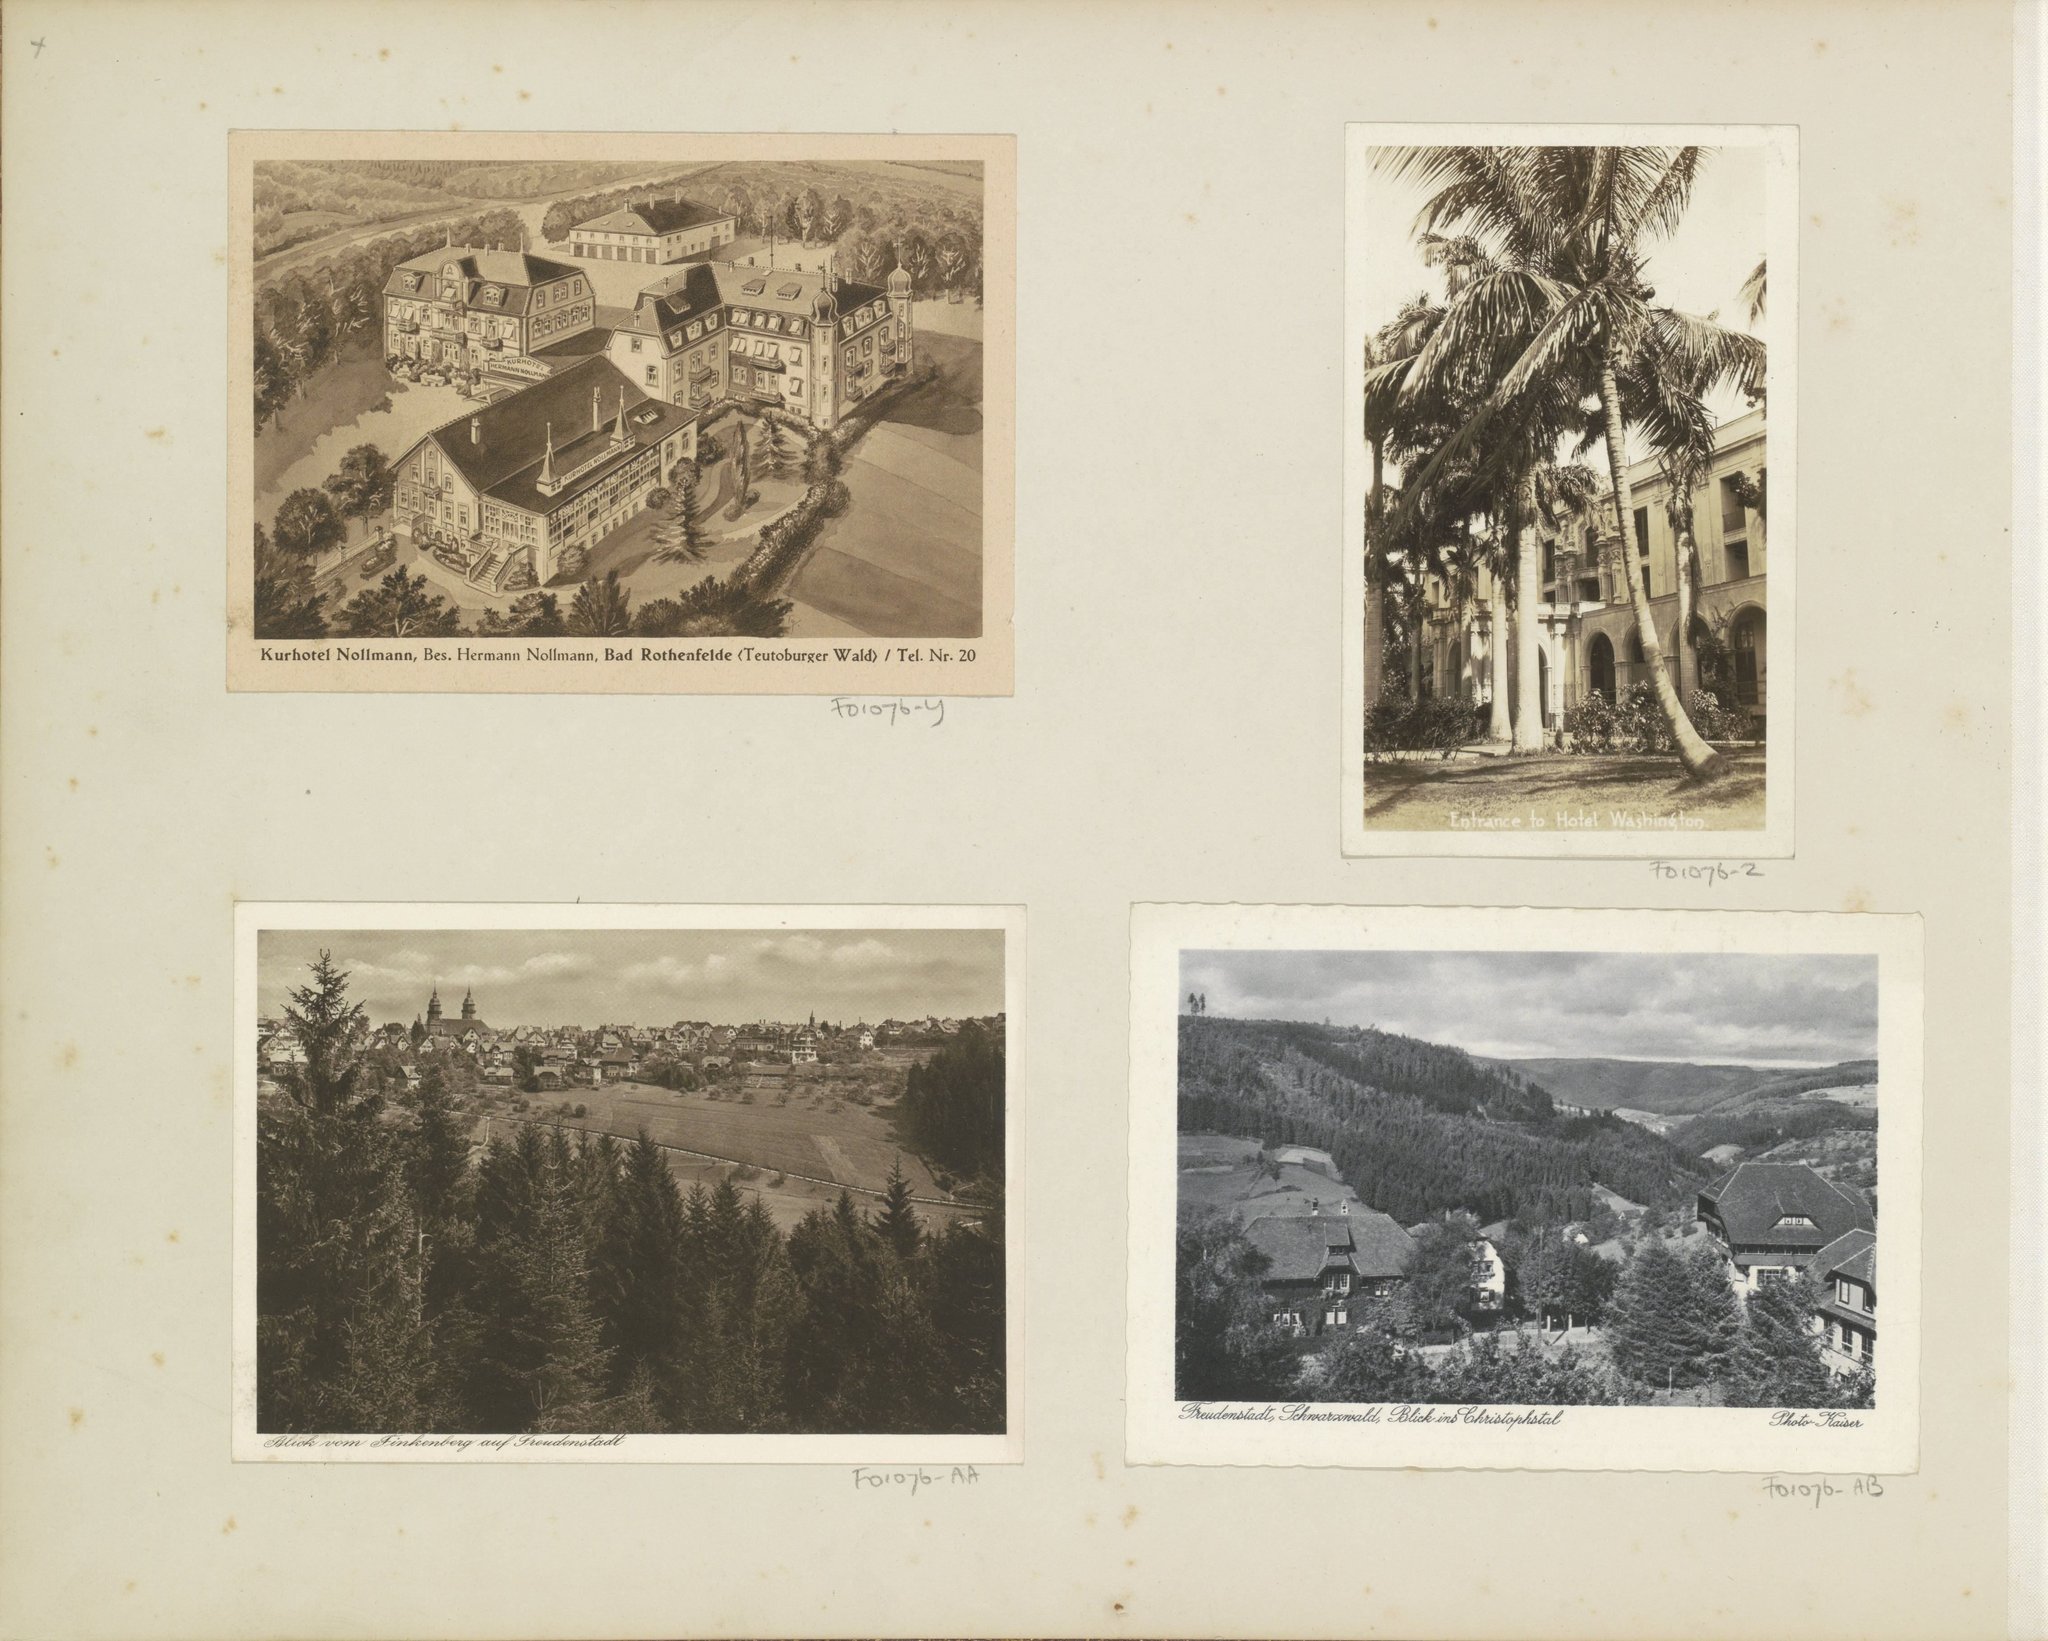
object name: photograph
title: Ingang van Hotel Washington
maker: Anonymous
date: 1900-1940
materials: cardboard, paper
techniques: gelatin silver print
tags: hotel, hostelry, inn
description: Onderdeel van Album met foto's van spoorwegen in Nederlands-Indië en prentbriefkaarten.